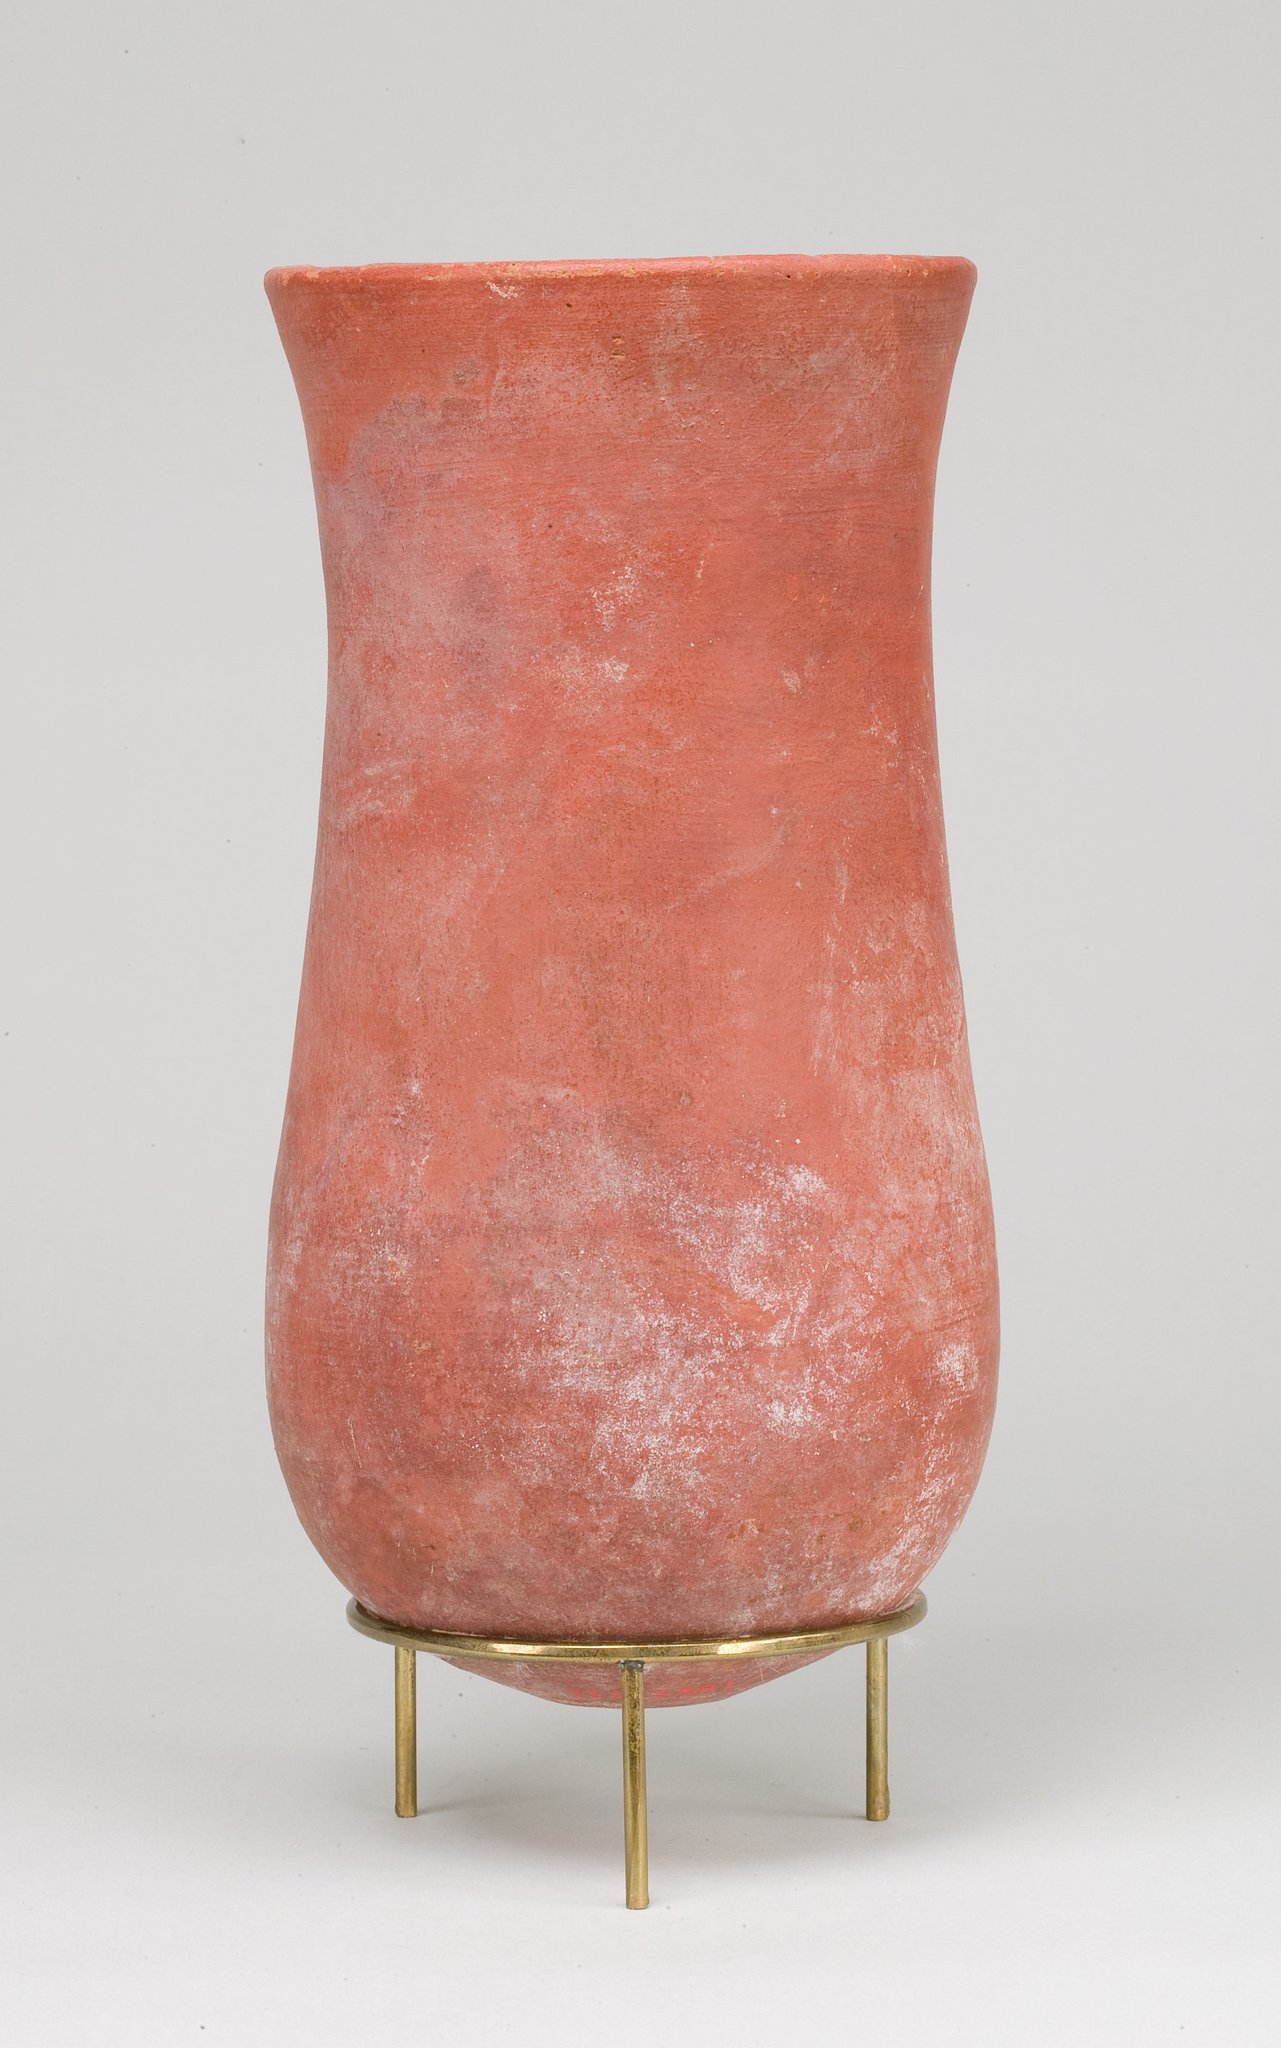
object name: jar, red ware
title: Red Ware Situla-shaped Jar from Malqata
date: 1390-1352 BCE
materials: mineral, pottery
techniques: wash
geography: egypt